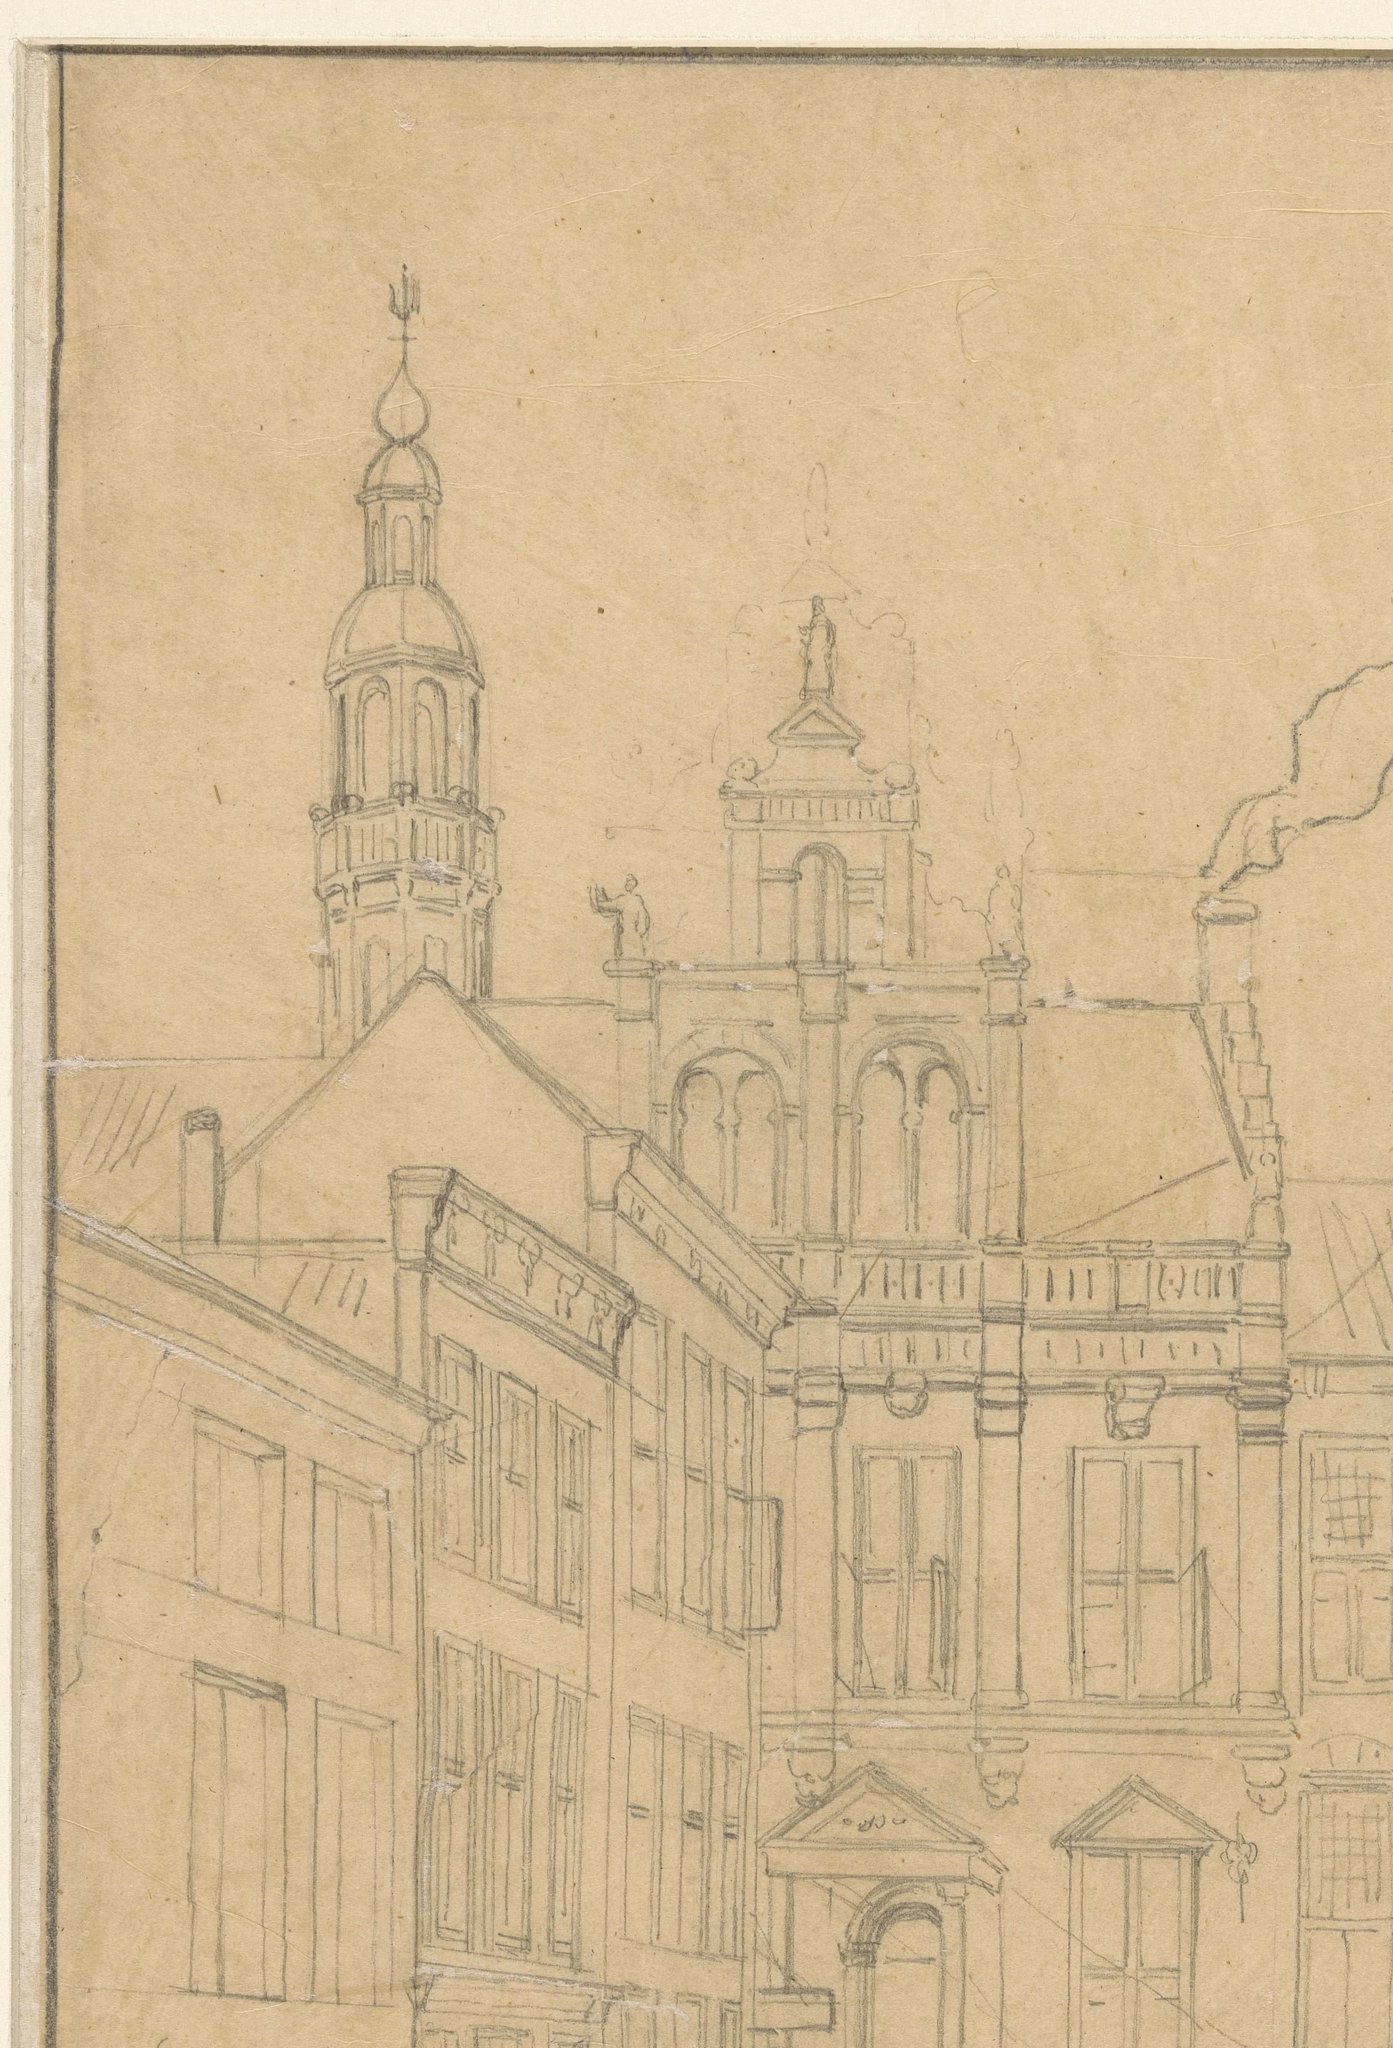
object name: design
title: Gezicht op het stadhuis van Den Haag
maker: frederik hendrik weissenbruch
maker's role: draughtsman, print maker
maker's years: 1828-1887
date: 1838-1887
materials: pencil, paper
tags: townhall, public road, the hague